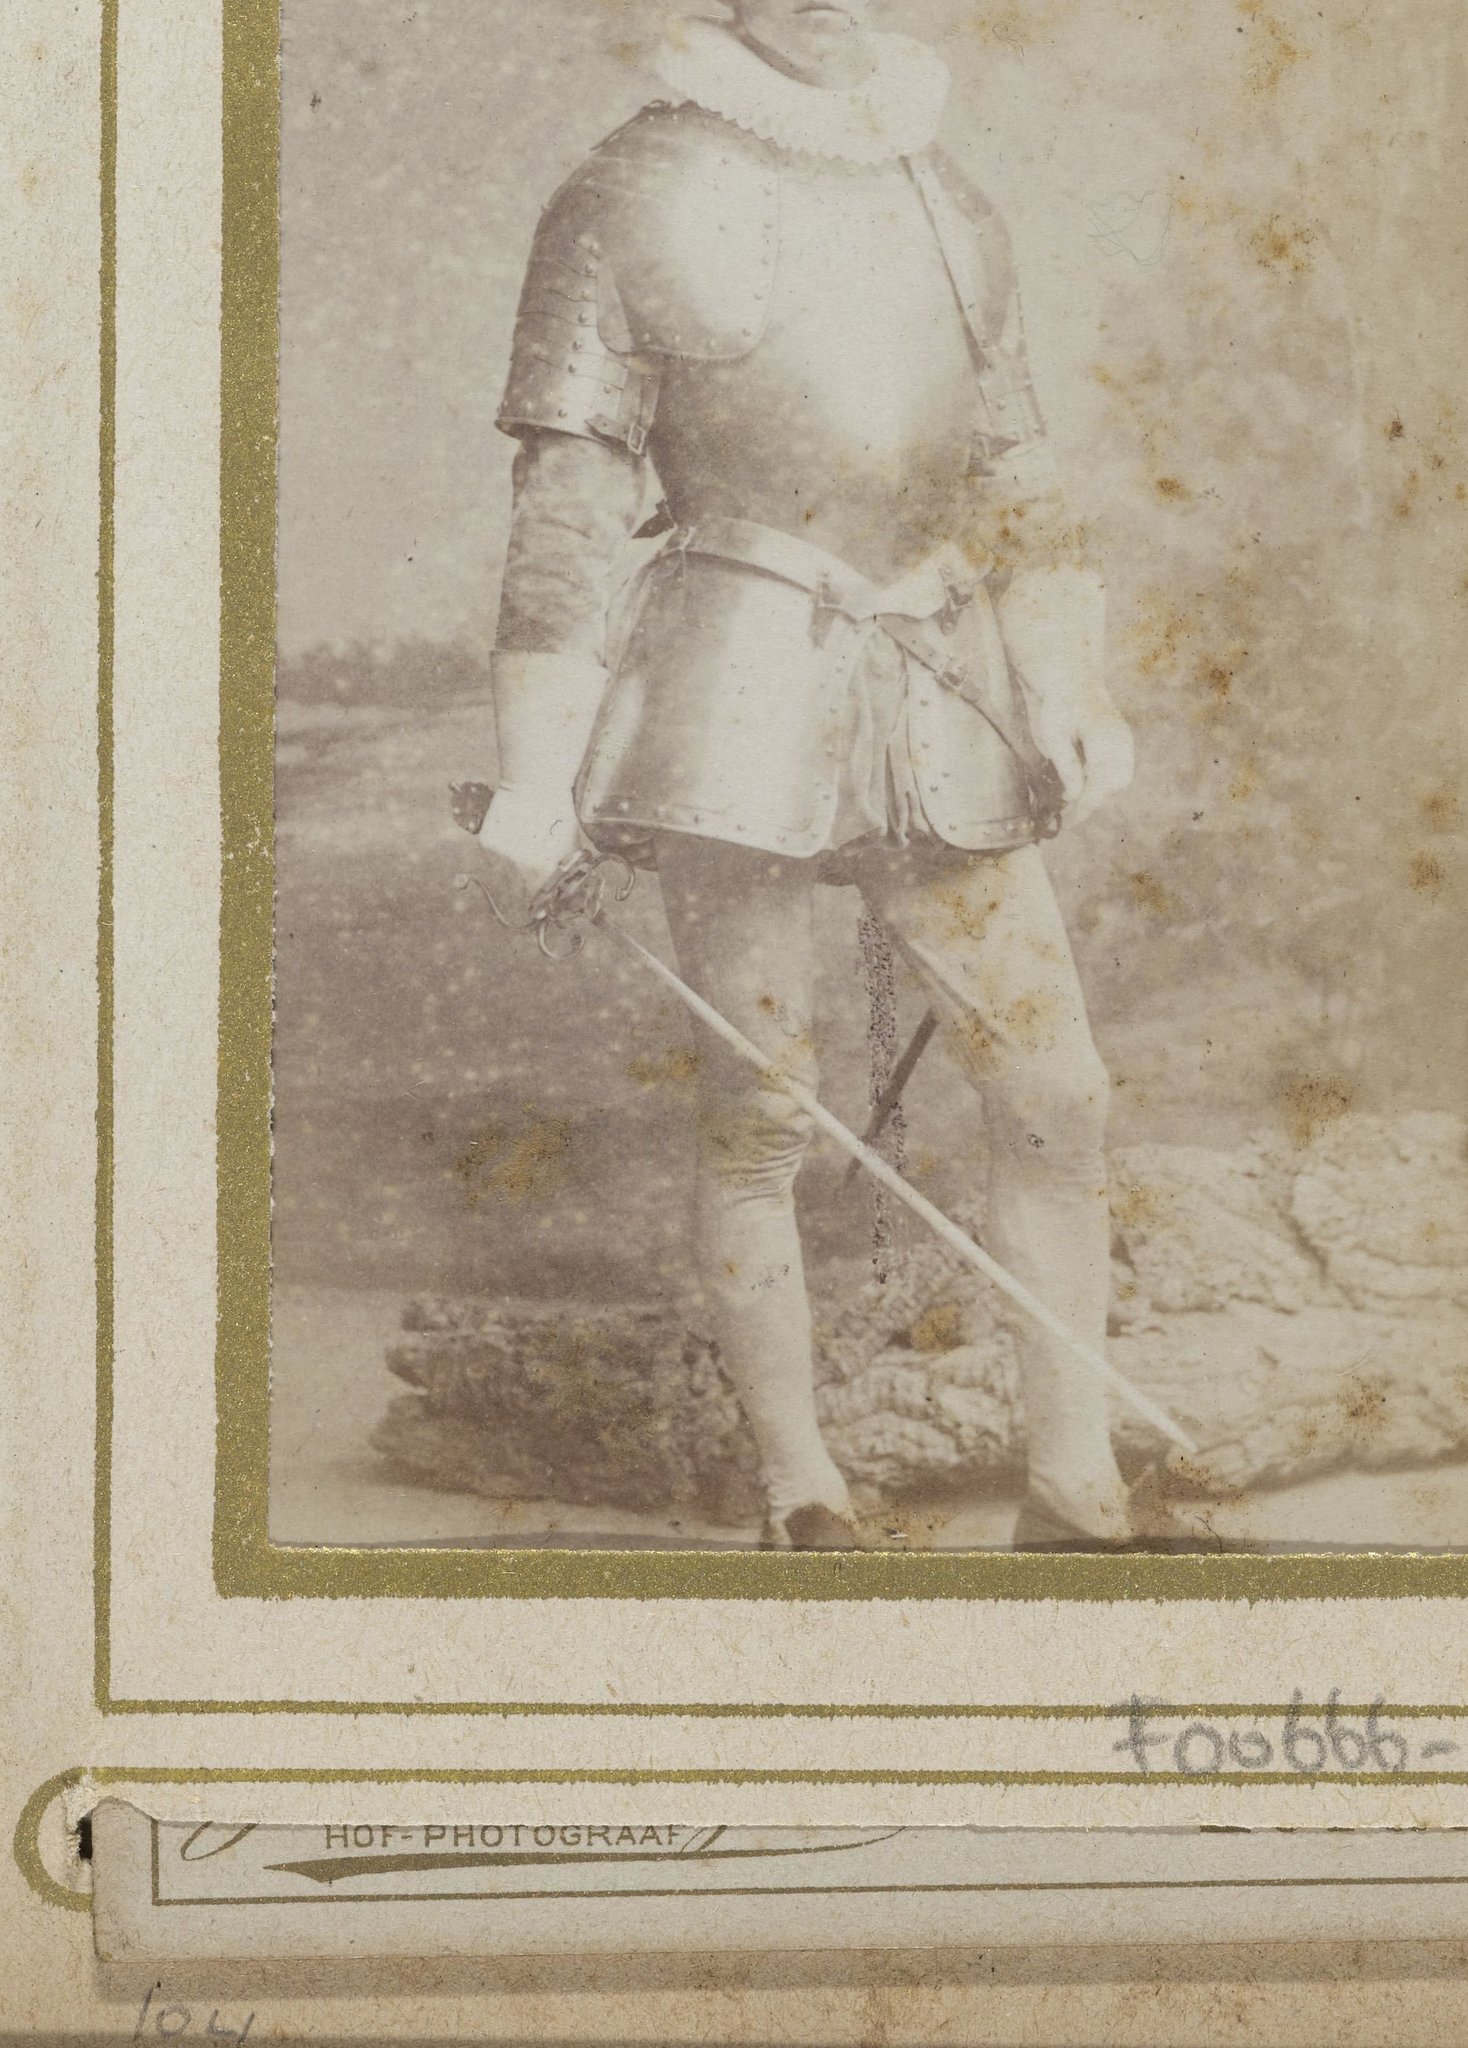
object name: photograph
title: Portret van een jonge man in harnas met degen, aangeduid als B. Formijne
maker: jan goedeljee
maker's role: fotograaf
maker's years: 1824-1905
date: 1860-1905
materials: cardboard, photographic support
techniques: albumen print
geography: leiden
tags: armour, historical persons, hacking and thrusting weapons: rapier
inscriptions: name: ‘B. Formijne/ 104’, inscription: ‘J. Goedeljee/ Photograaf/ Z. K. H. PRINS ALEXANDER/ der Nederlanden/ PRINS van ORANJE/ en H. K. H./ PRINSES HENDRIK/ der Nederlanden/ Hoogewoerd 160/ nabij de Plantage.’